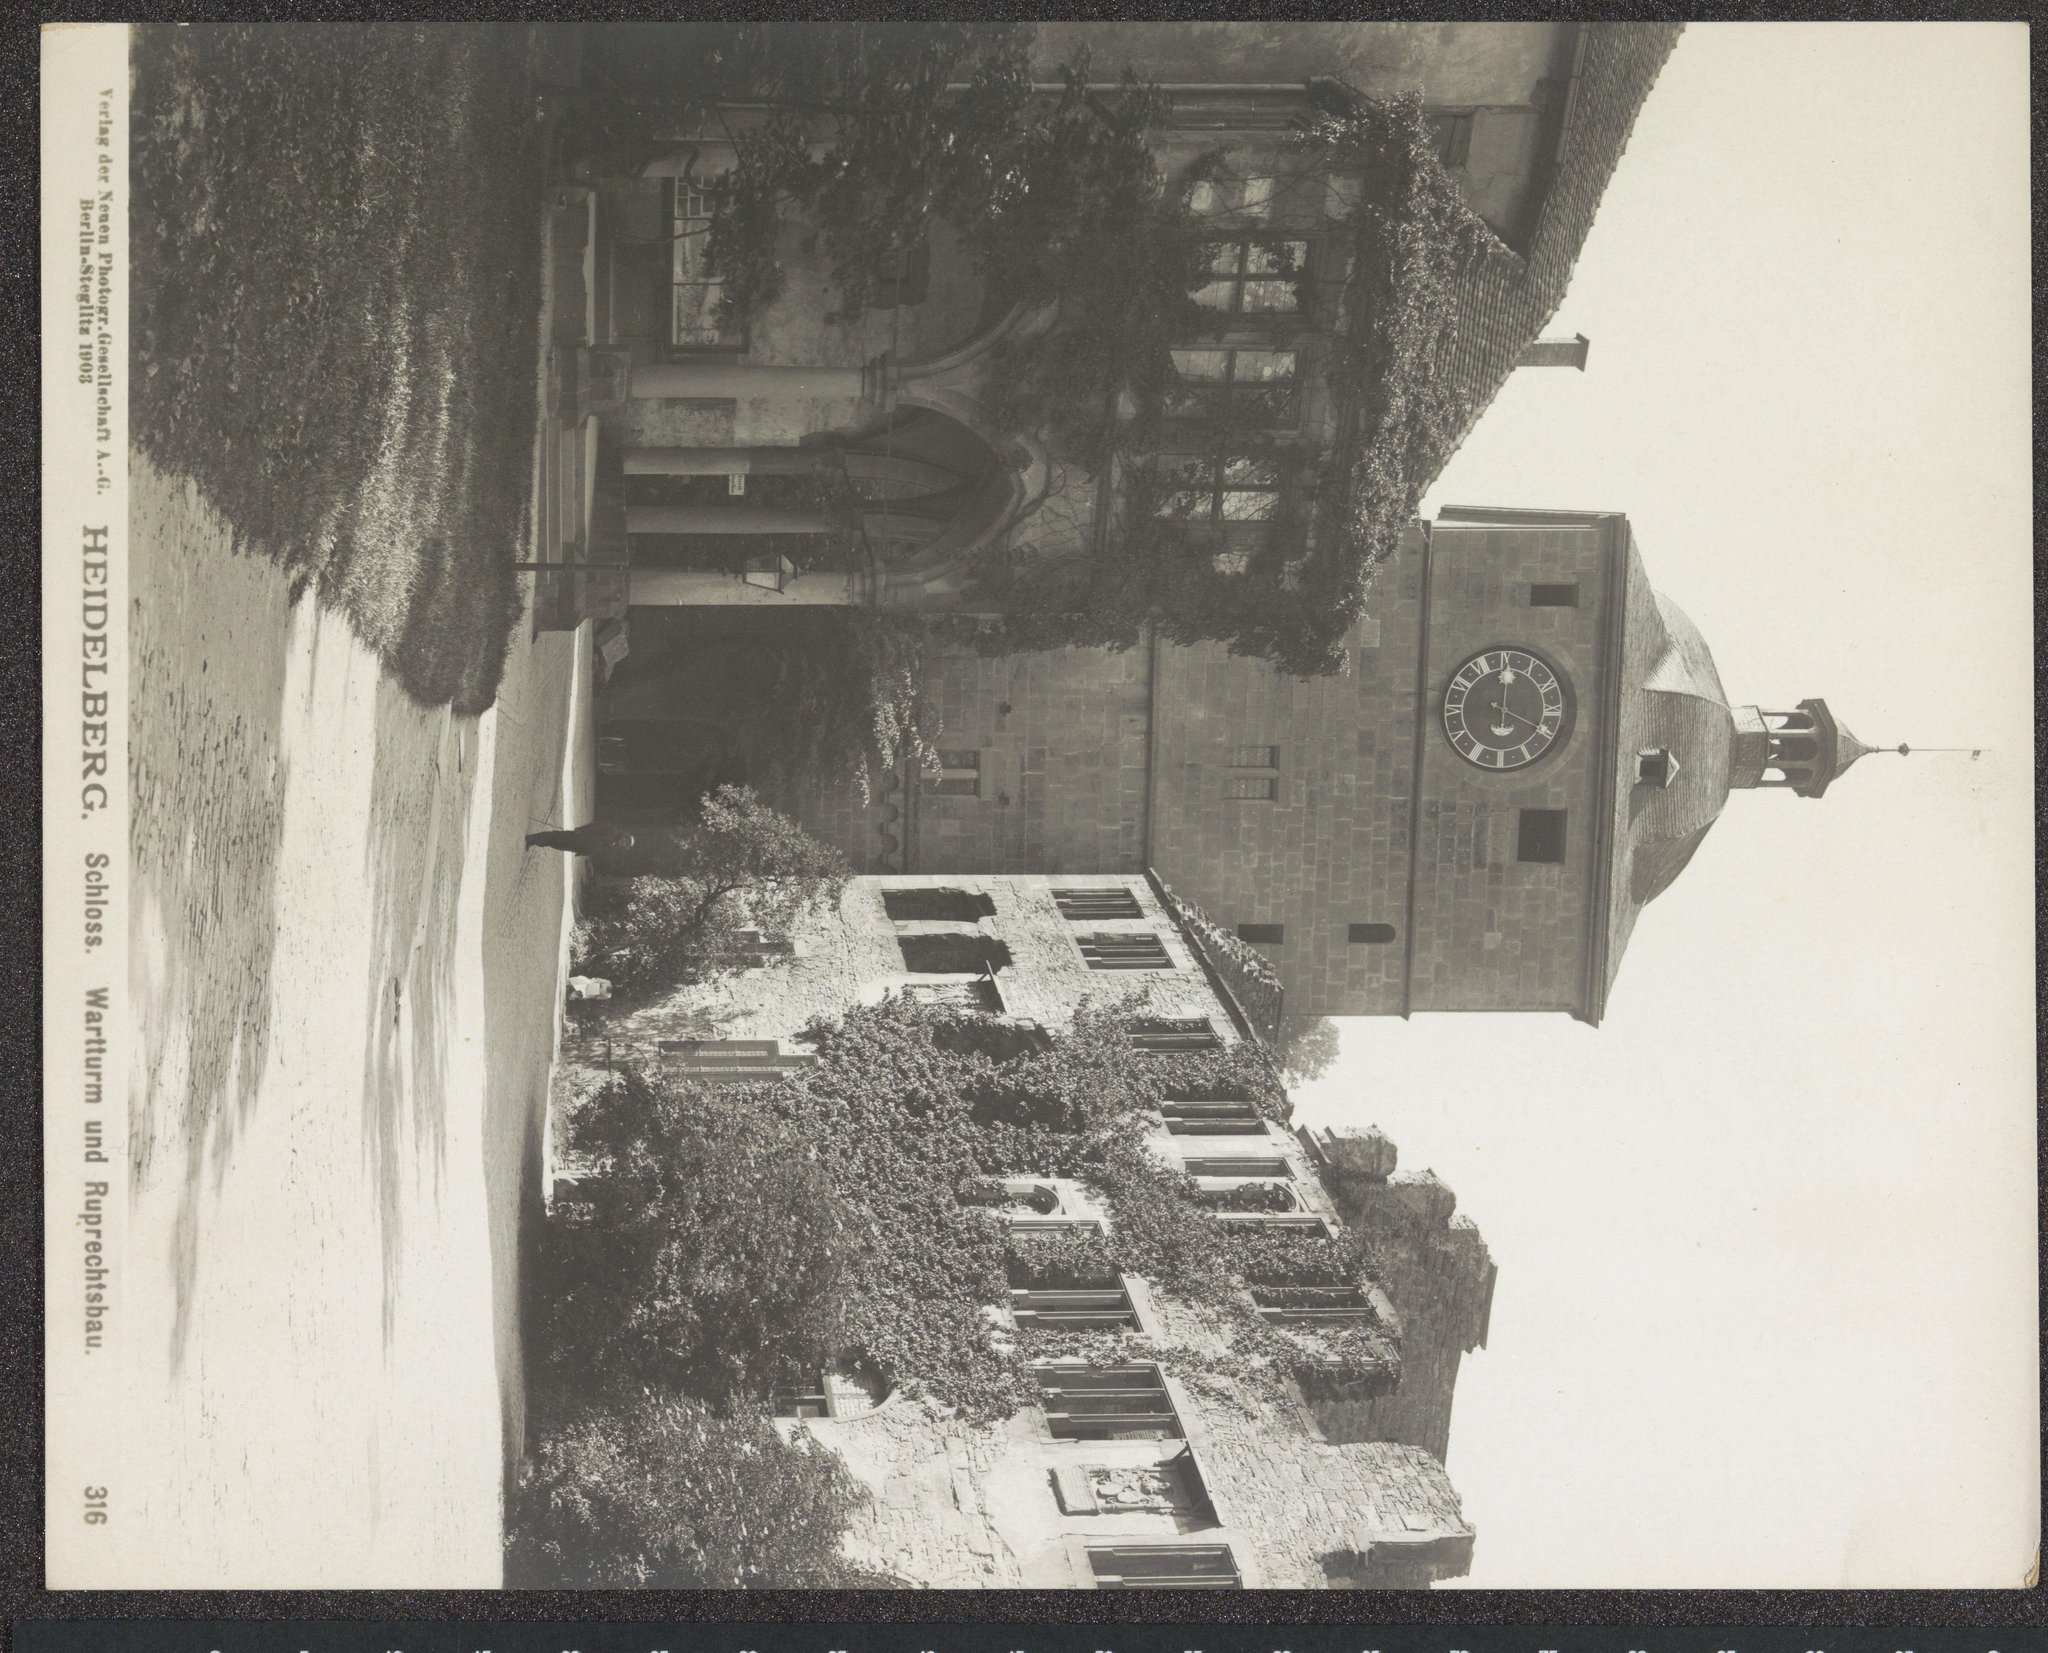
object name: photograph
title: Heidelberg. Schloss. Wartturm und Ruprechtsbau.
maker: Anonymous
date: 1903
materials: photographic support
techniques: gelatin silver print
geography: heidelberg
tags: castle, courtyard, prospect of city, town panorama, silhouette of city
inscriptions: number: ‘316’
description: Onderdeel van Fotoalbum met opnames van Heidelberg en Schloss Heidelberg.